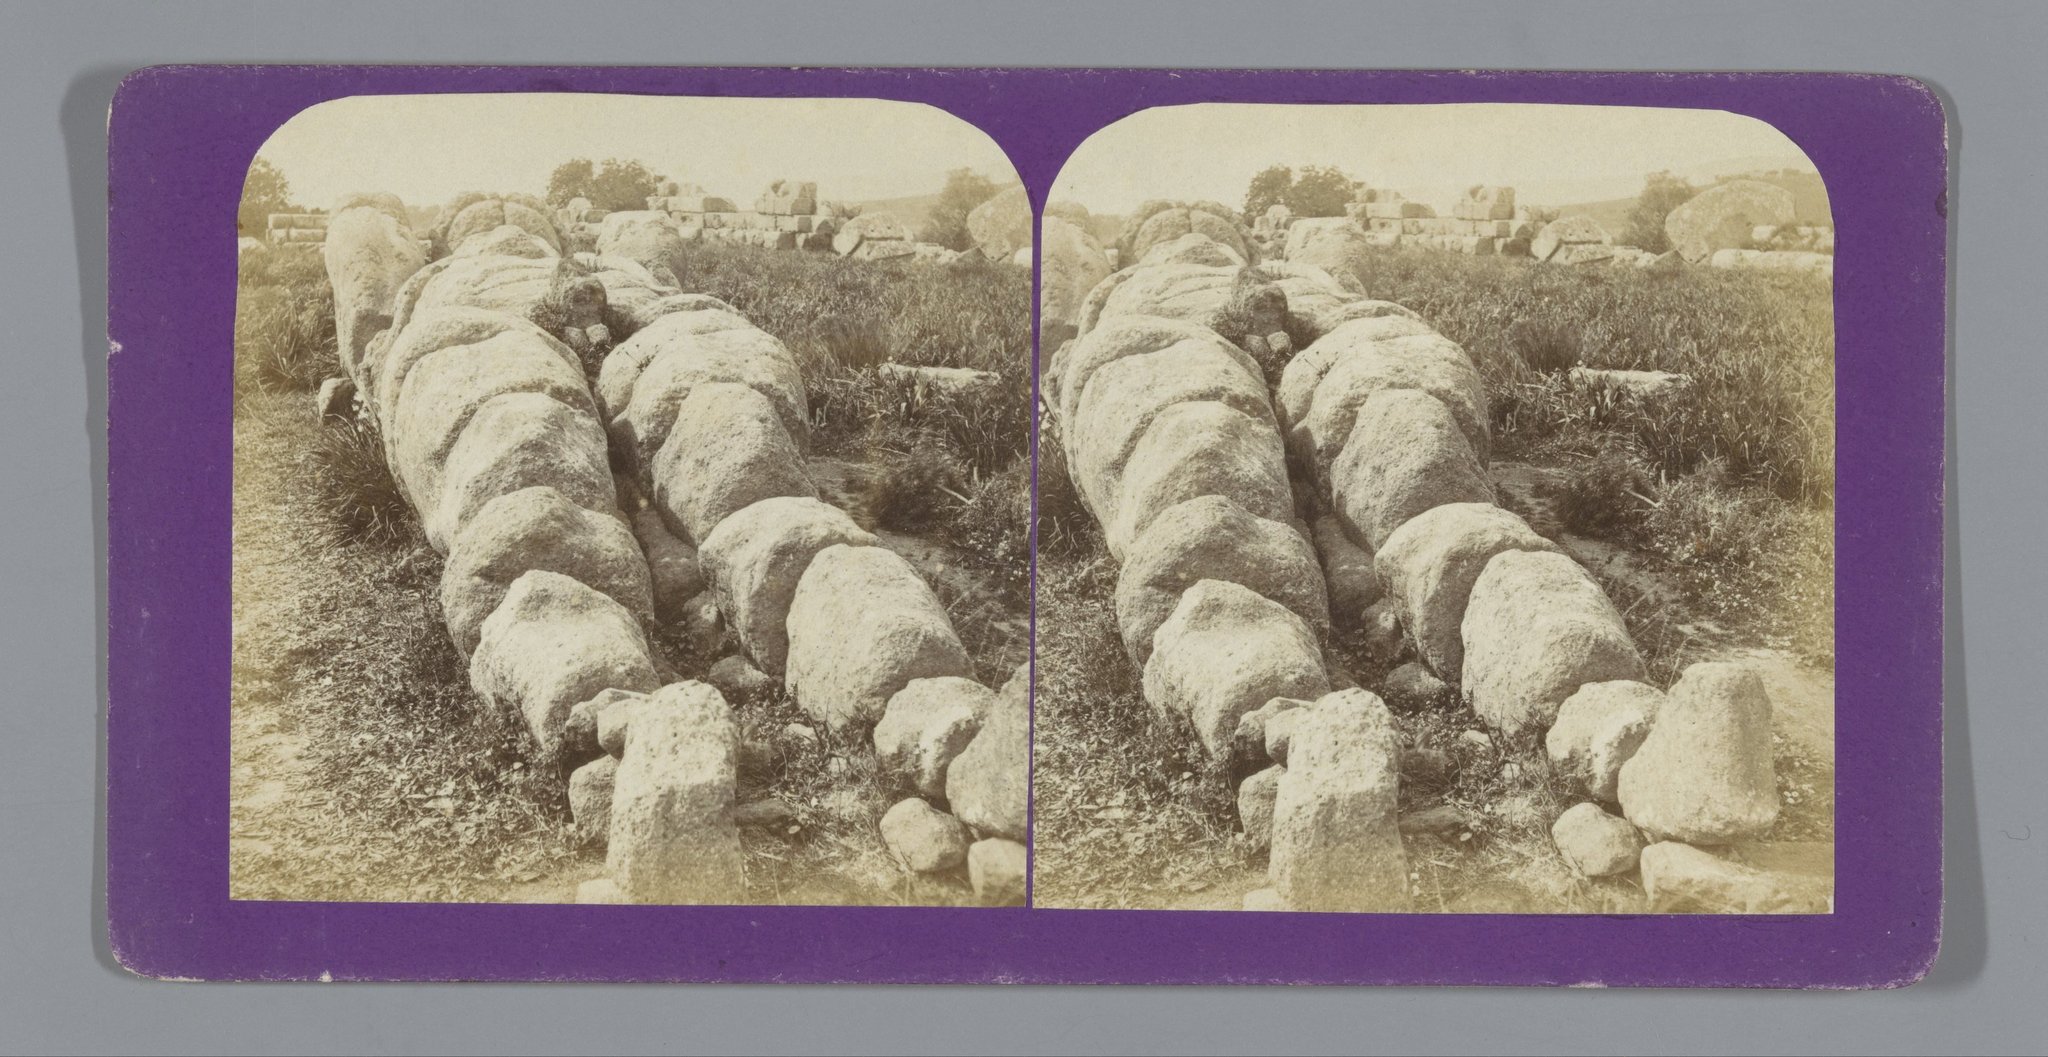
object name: stereograph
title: Gezicht op een gevallen atlant van de Tempel van Zeus, Agrigento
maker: jean andrieu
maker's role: fotograaf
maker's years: 1816-1872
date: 1862-1876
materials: cardboard, paper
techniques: albumen print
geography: agrigento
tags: caryatids ~ architecture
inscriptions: title: ‘1320 Cariatide du temple de Jupiter Girgenti’